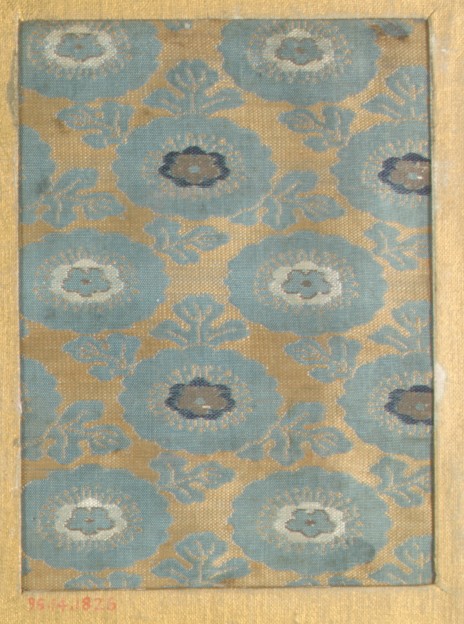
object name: piece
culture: japanese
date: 1701-1900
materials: silk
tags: leaves